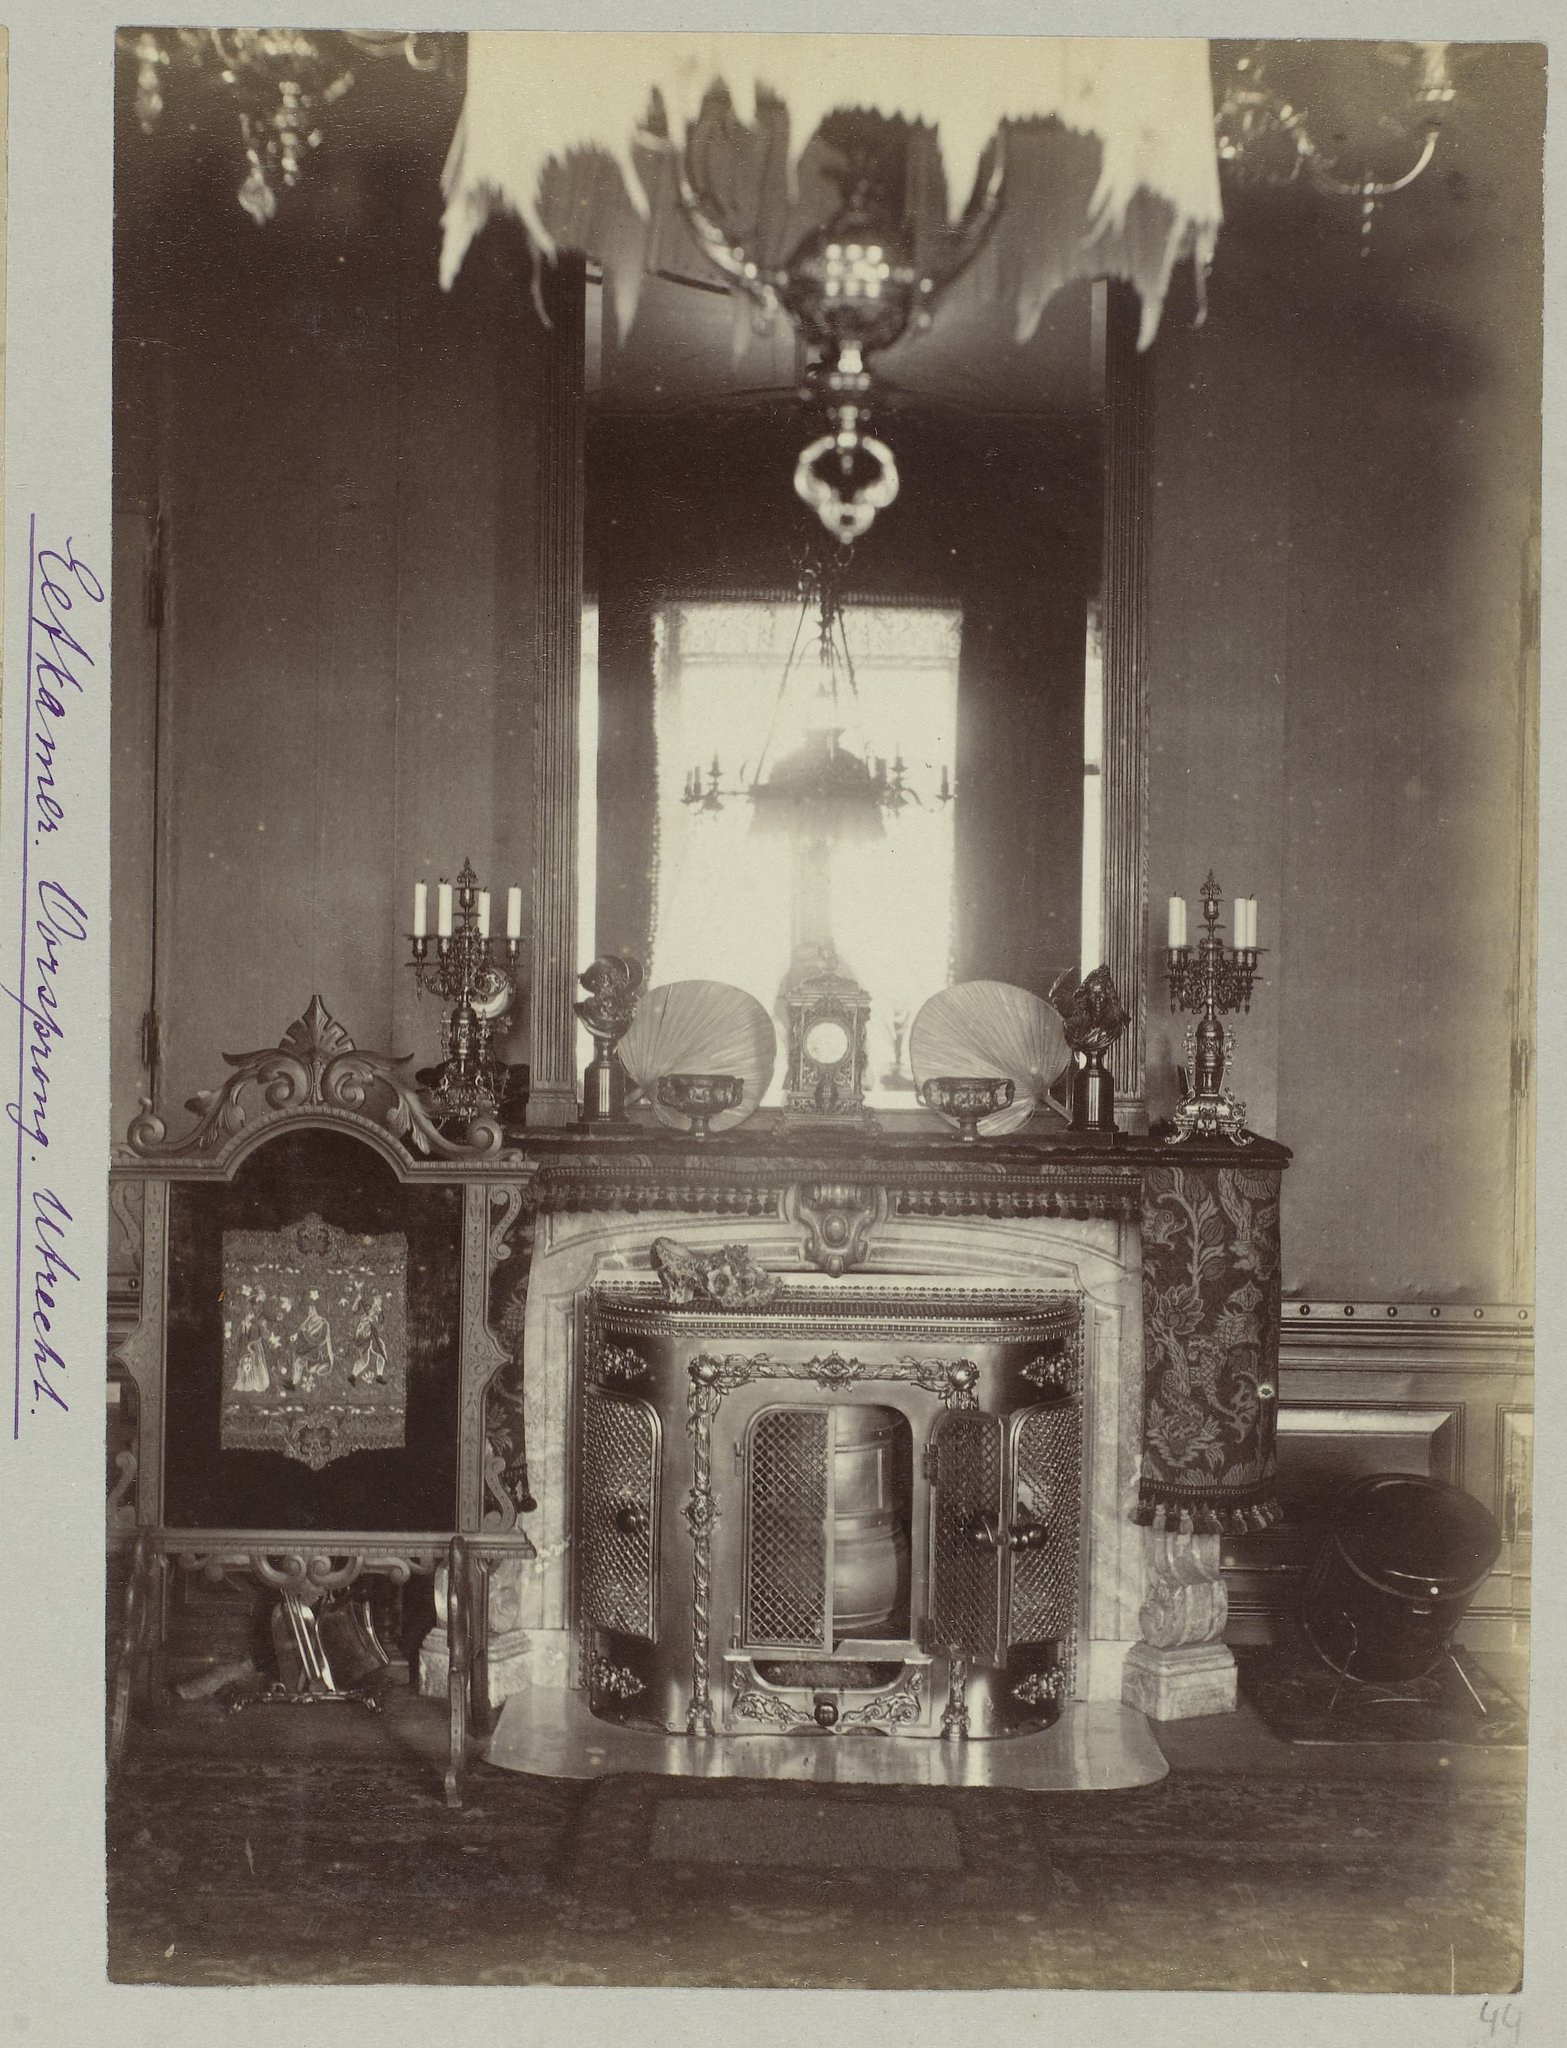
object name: photograph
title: Eetkamer in herenhuis De Oorsprong in Utrecht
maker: henry pauw van wieldrecht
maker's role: fotograaf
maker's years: 1863-1912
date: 1889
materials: paper, photographic support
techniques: albumen print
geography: netherlands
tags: utrecht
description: De eetkamer met een open haard en schouw in herenhuis De Oorsprong in Utrecht. Links op het albumblad geschreven: Eetkamer oorsprong Utrecht.